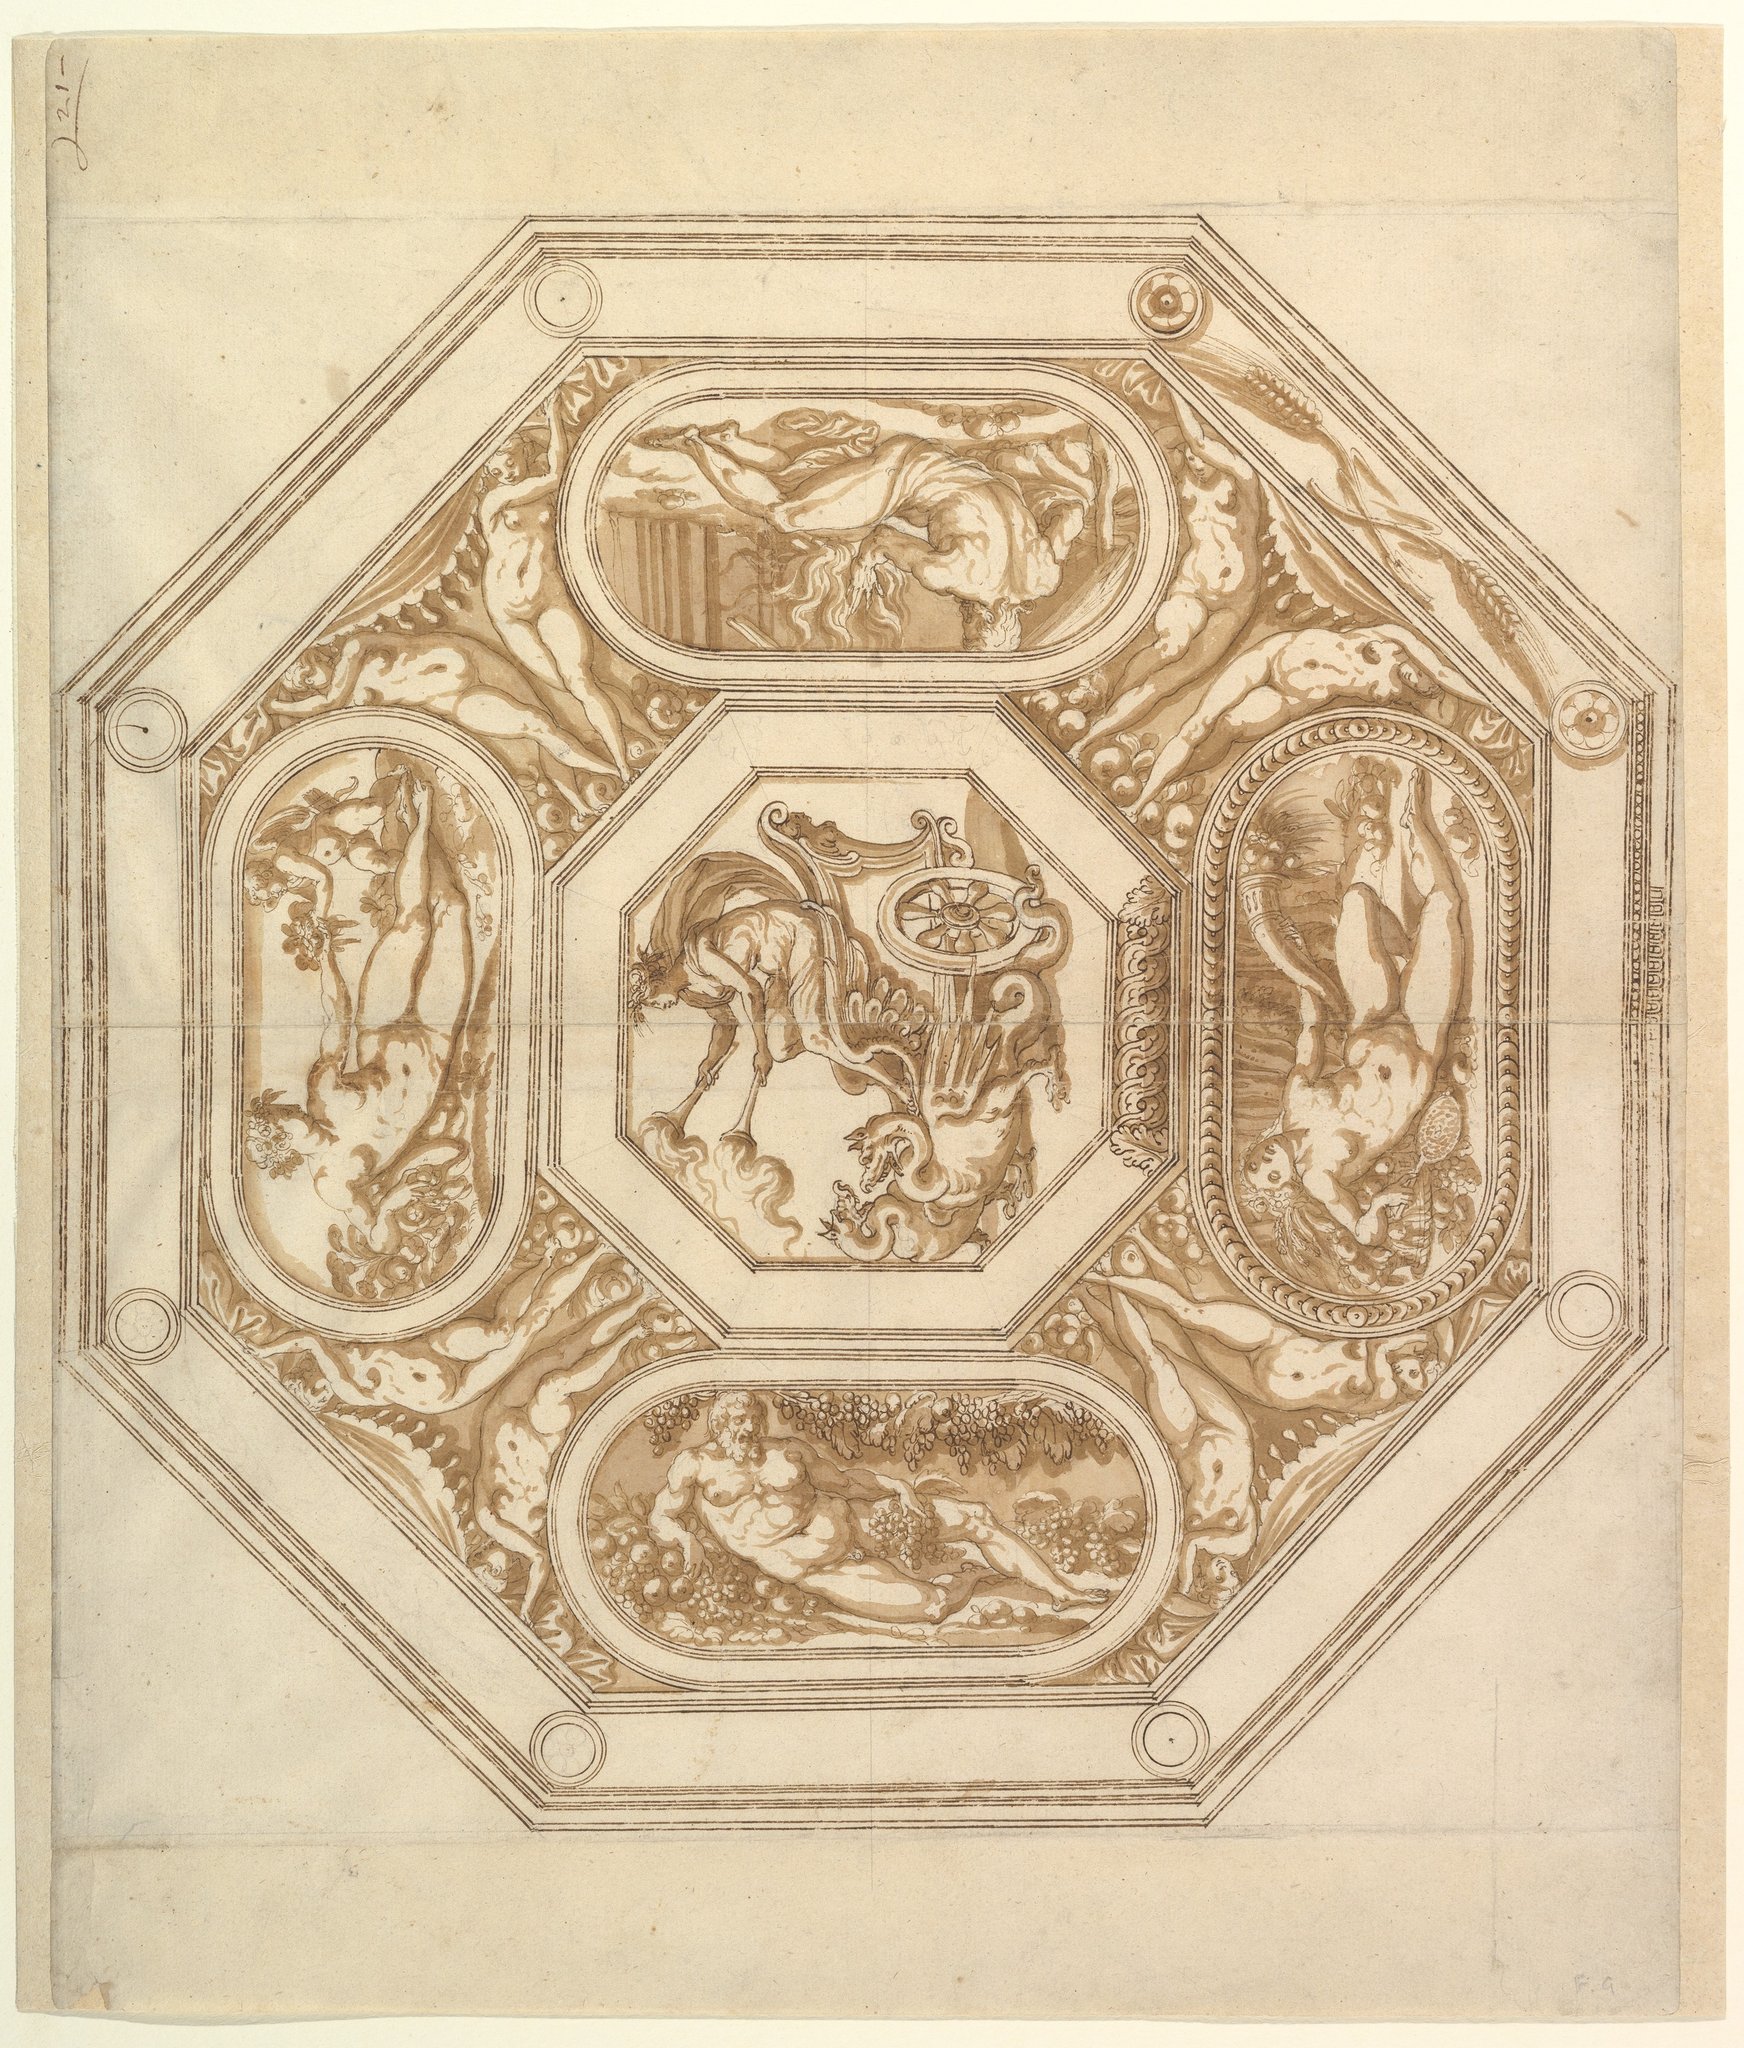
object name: ornament architecture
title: Design for an Octagonal Ceiling (or Dish?)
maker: ottavio strada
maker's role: artist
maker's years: 1550-1606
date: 1510-1563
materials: chalk, ink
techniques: brush, pen, wash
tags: male nudes,female nudes